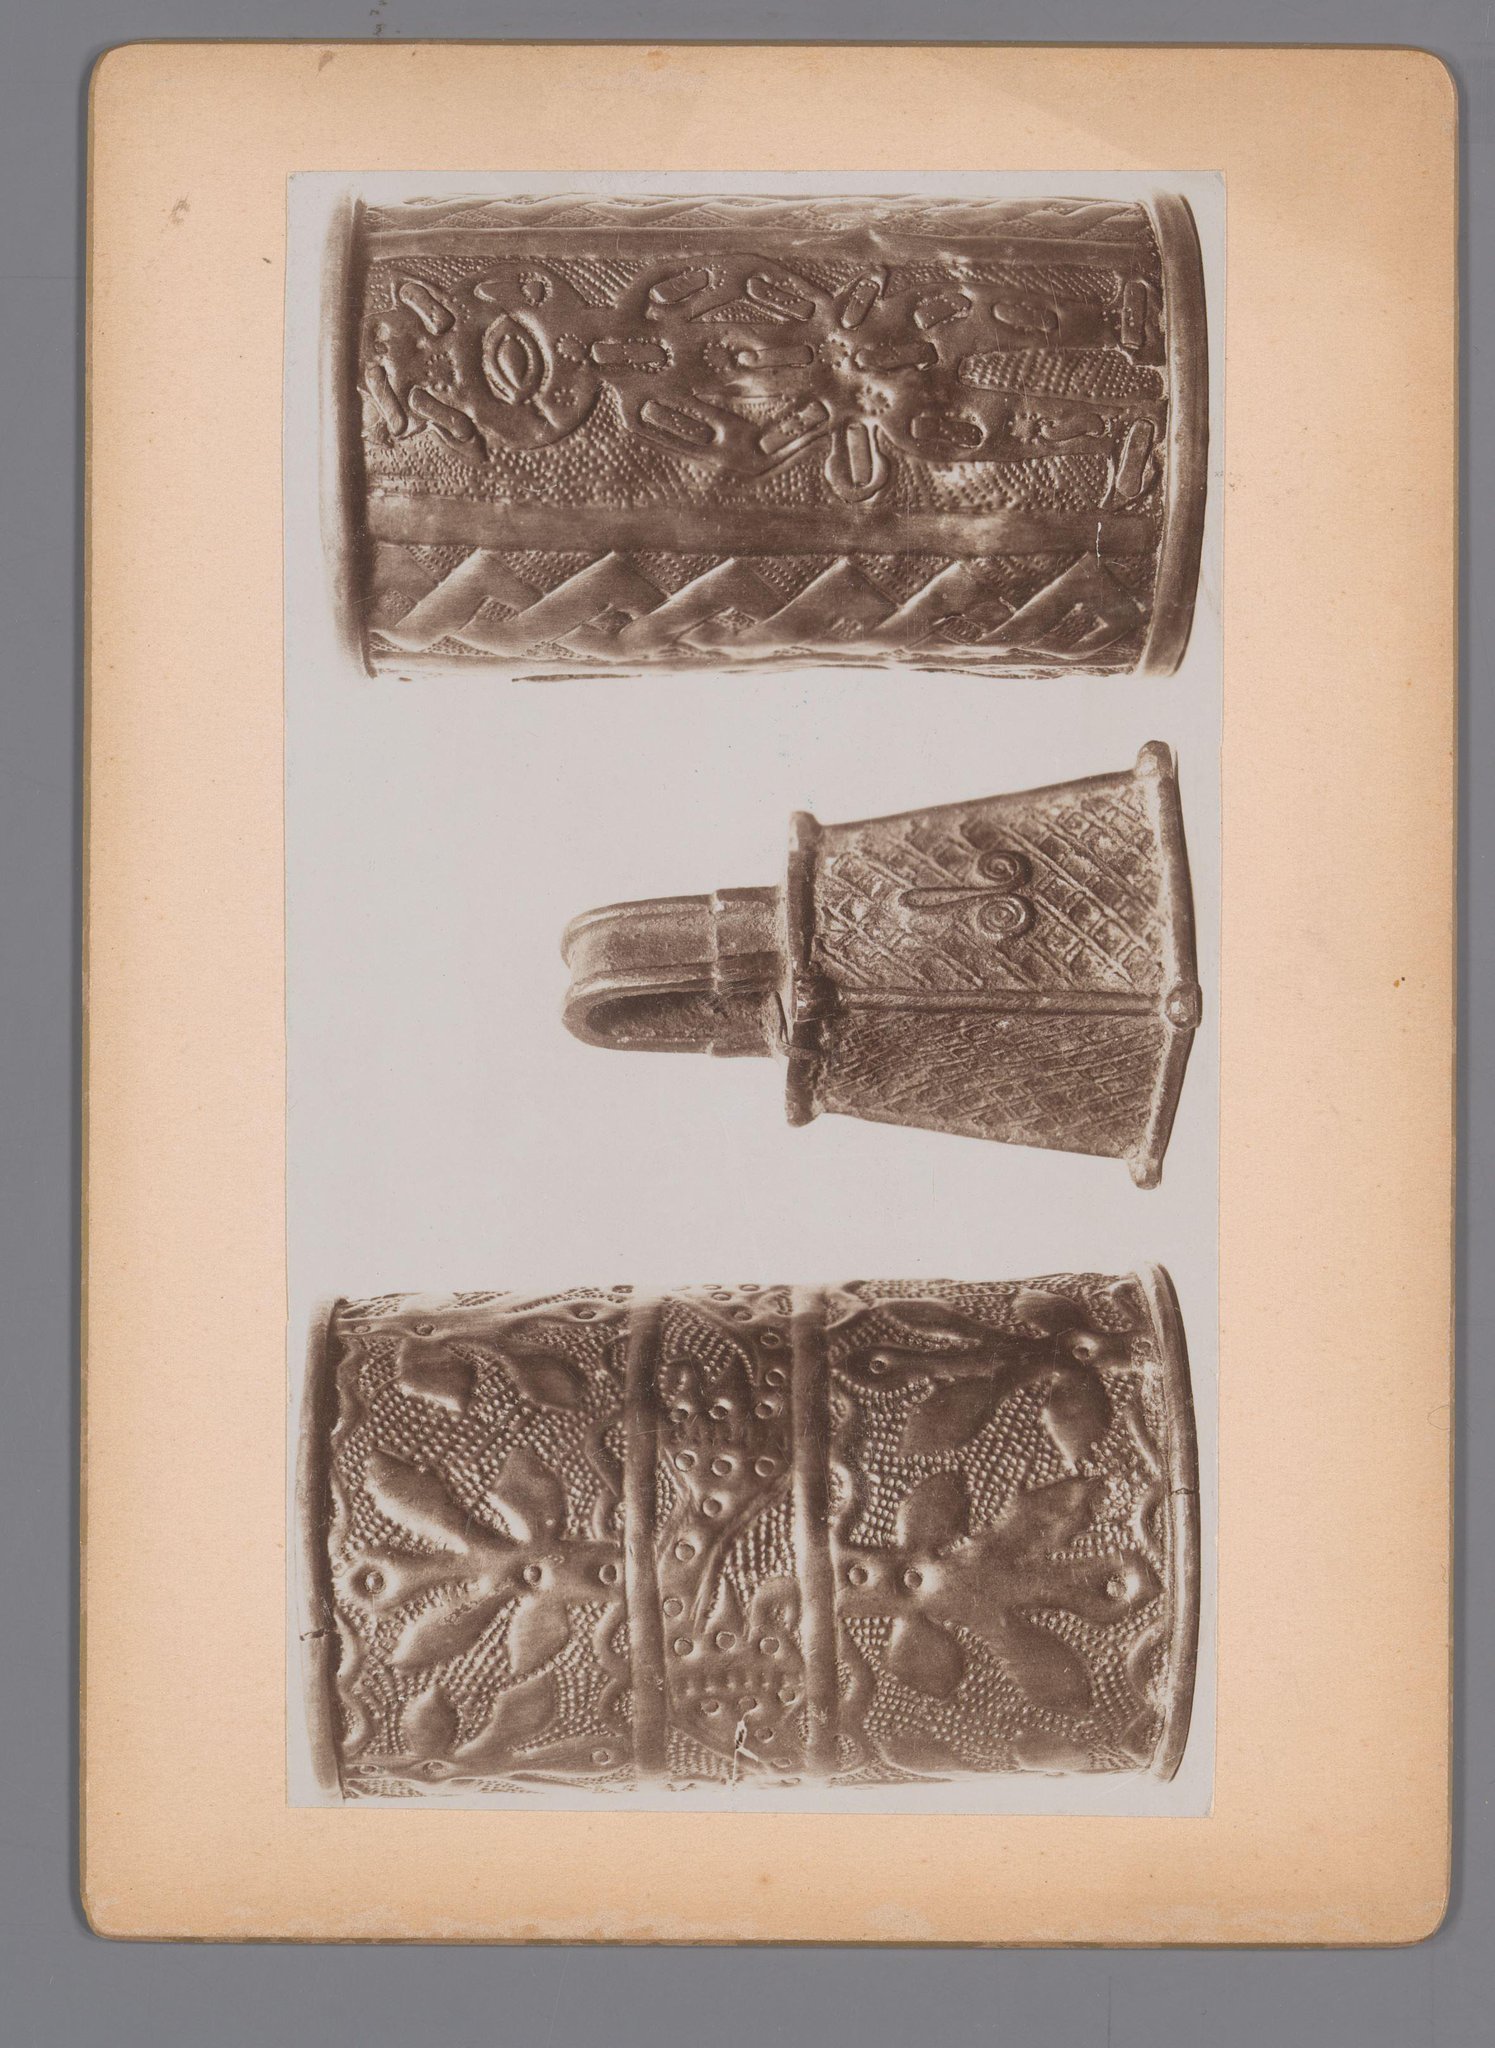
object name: photograph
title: Twee armringen en een bel van brons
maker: Anonymous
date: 1880-1940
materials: paper, cardboard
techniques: collodion silver print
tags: bracelet, wristlet, bell ~ acoustic signalling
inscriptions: collector's mark: ‘Rijks-etnografisch-instituut’, inscription: ‘Twee armringen en een bel van/ brons van Benin, West Afrika/ Rijks Etnografisch Museum/ Serie 1164/ No. 8.9.10’